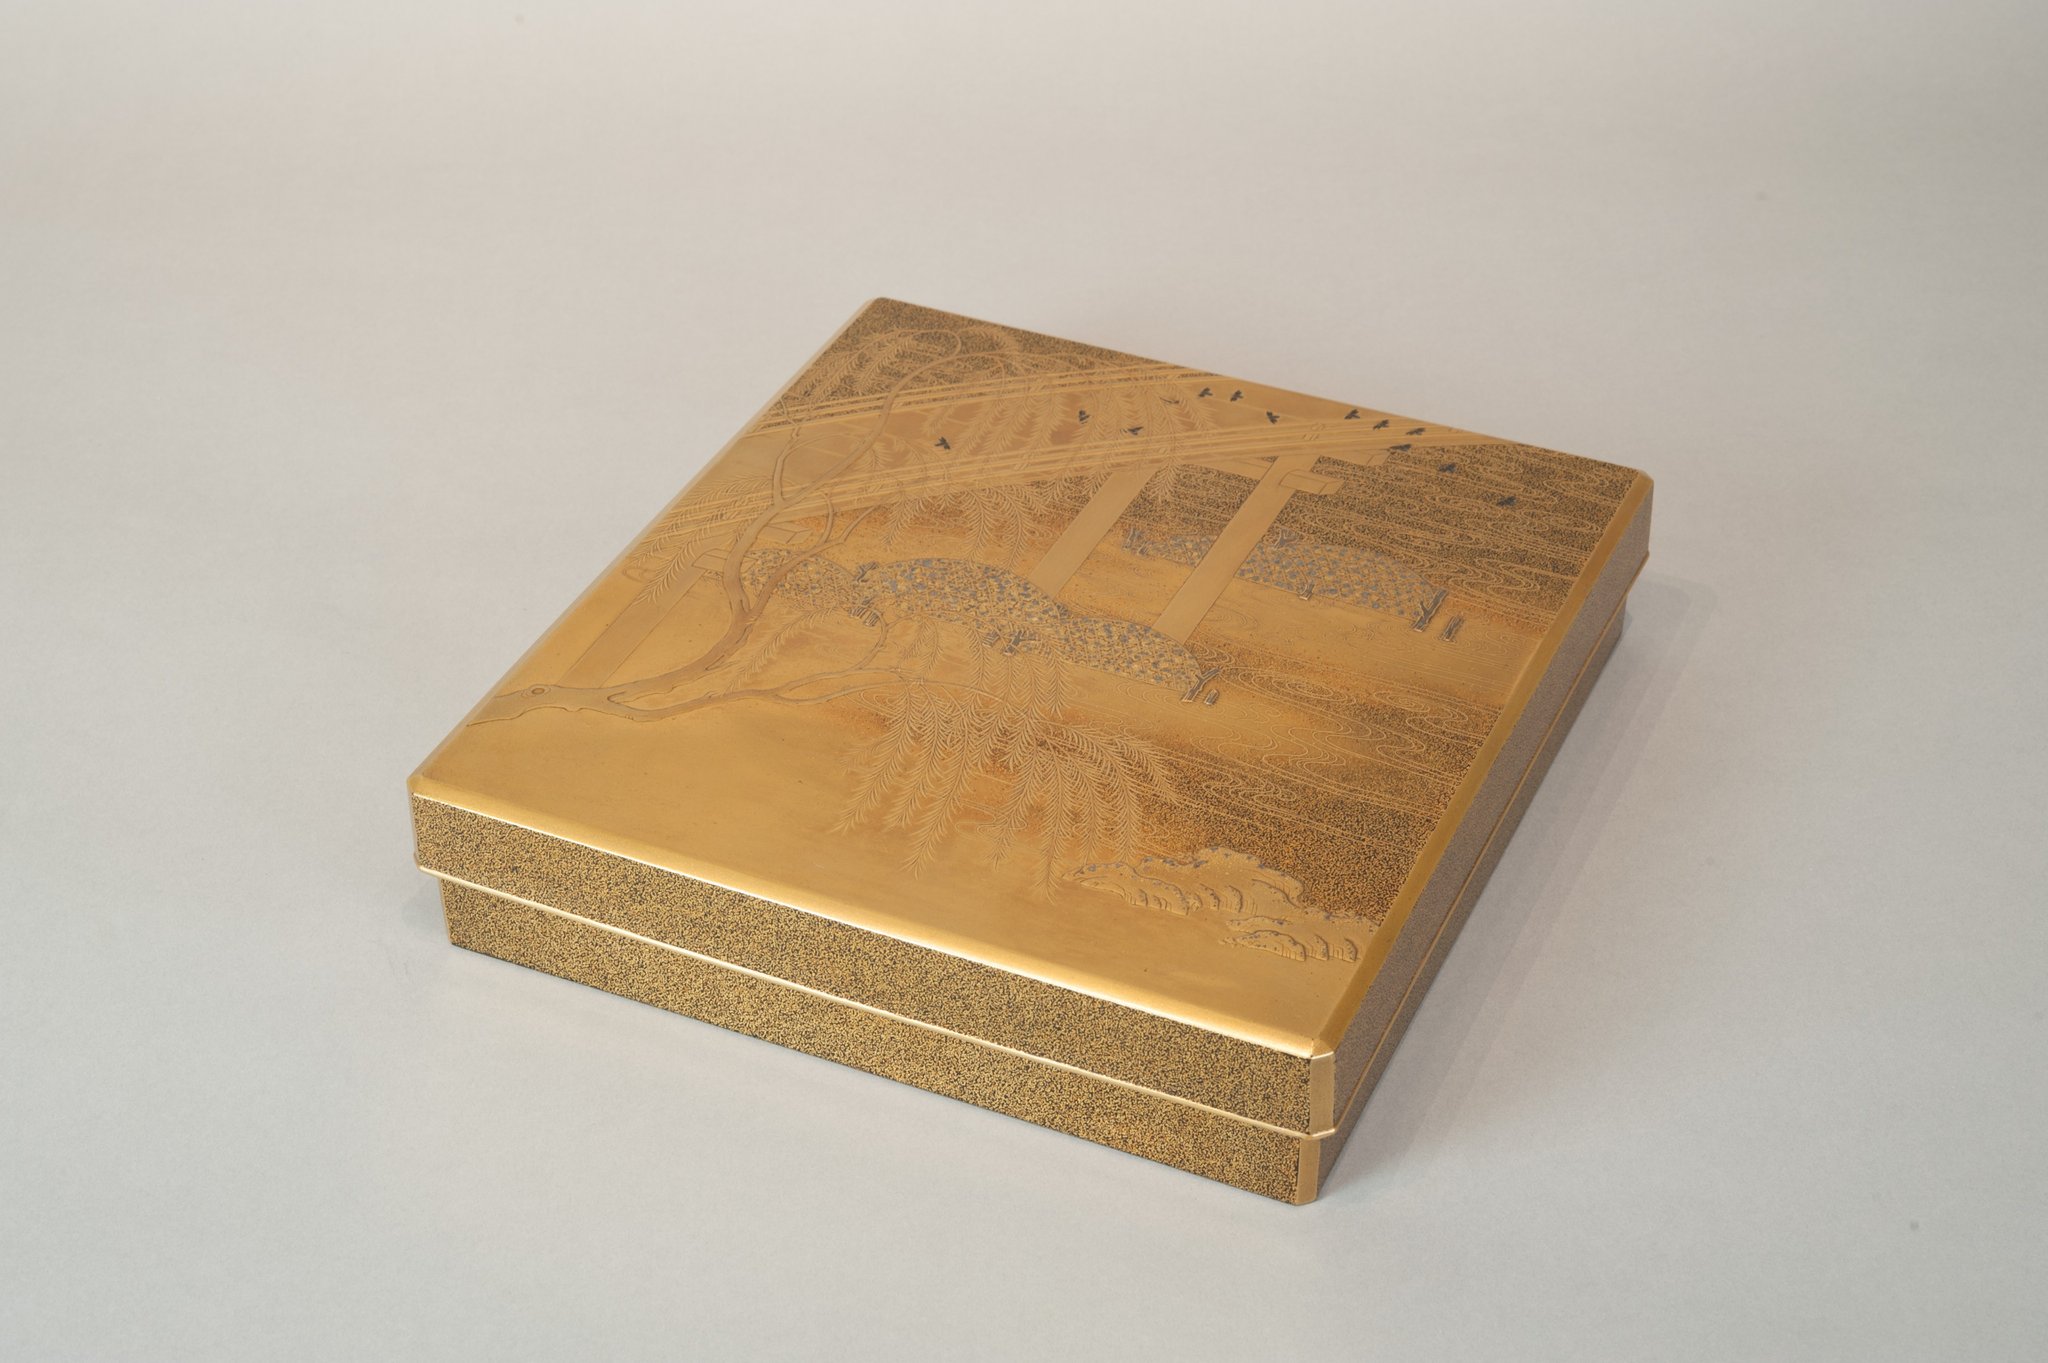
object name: writing box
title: Box for Inkstone and Writing Implements (Suzuribako)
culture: japanese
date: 1801-1900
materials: gold, lacquer, shell, wood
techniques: inlay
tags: bridges,rivers